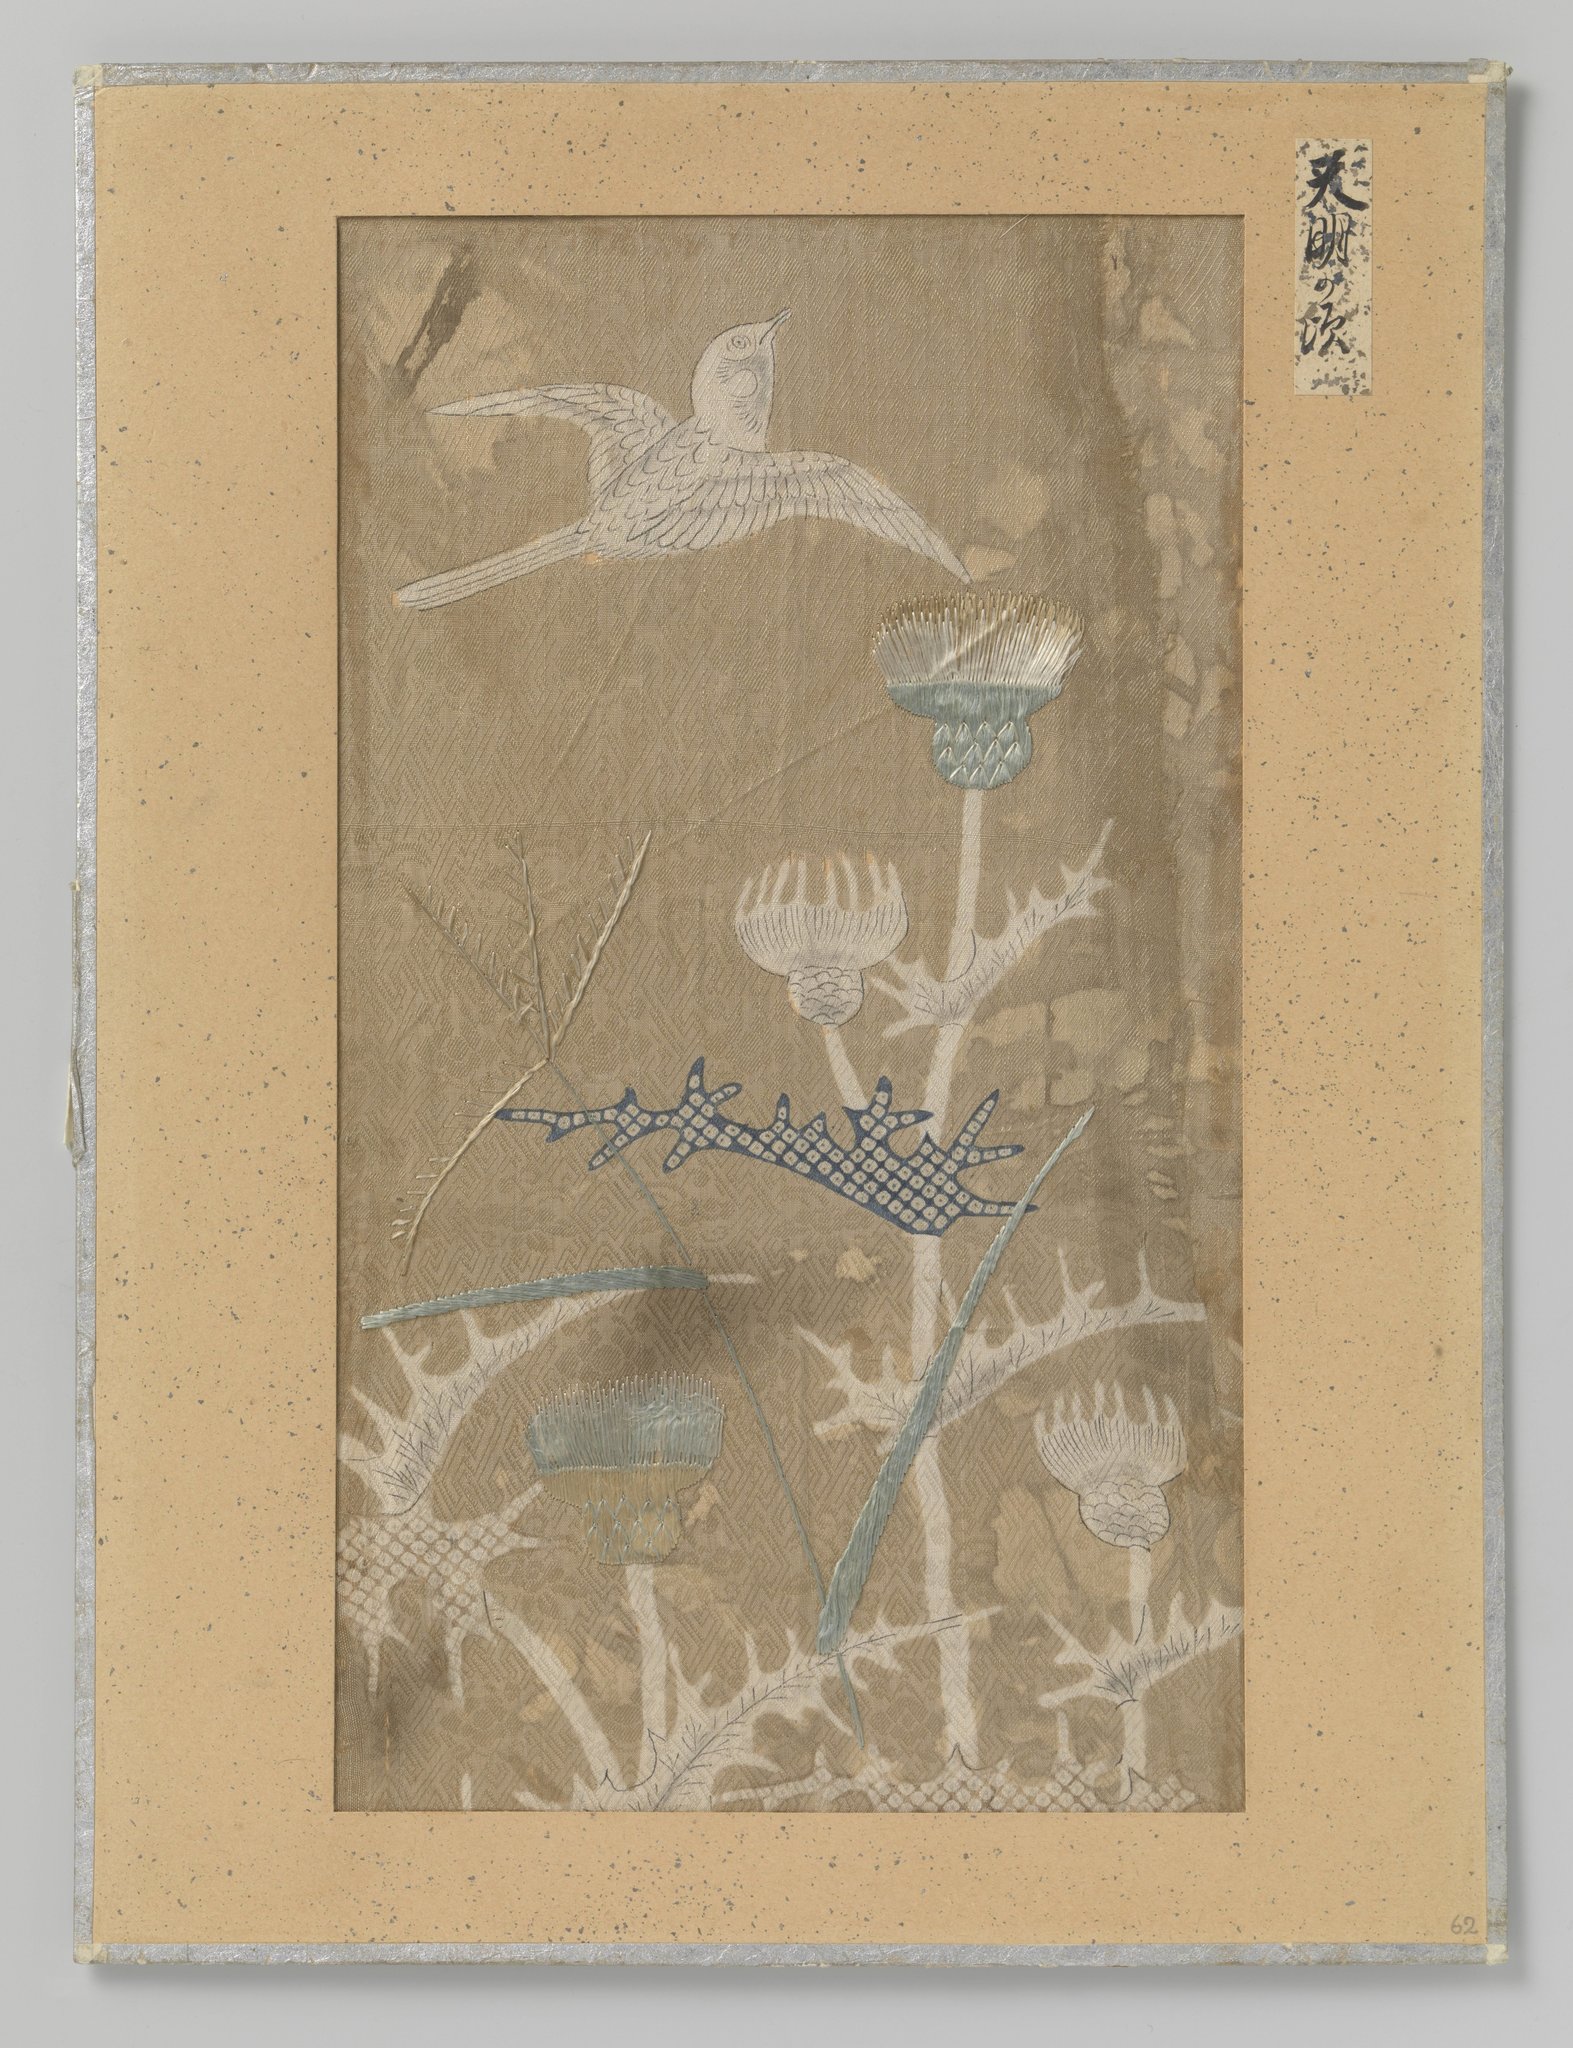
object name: fragment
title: Fragment textiel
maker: Anonymous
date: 1781-1789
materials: silk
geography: japan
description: Textielfragment, borduursels en druk van een vogel en distels op een lichtbruine damast achtergrond.